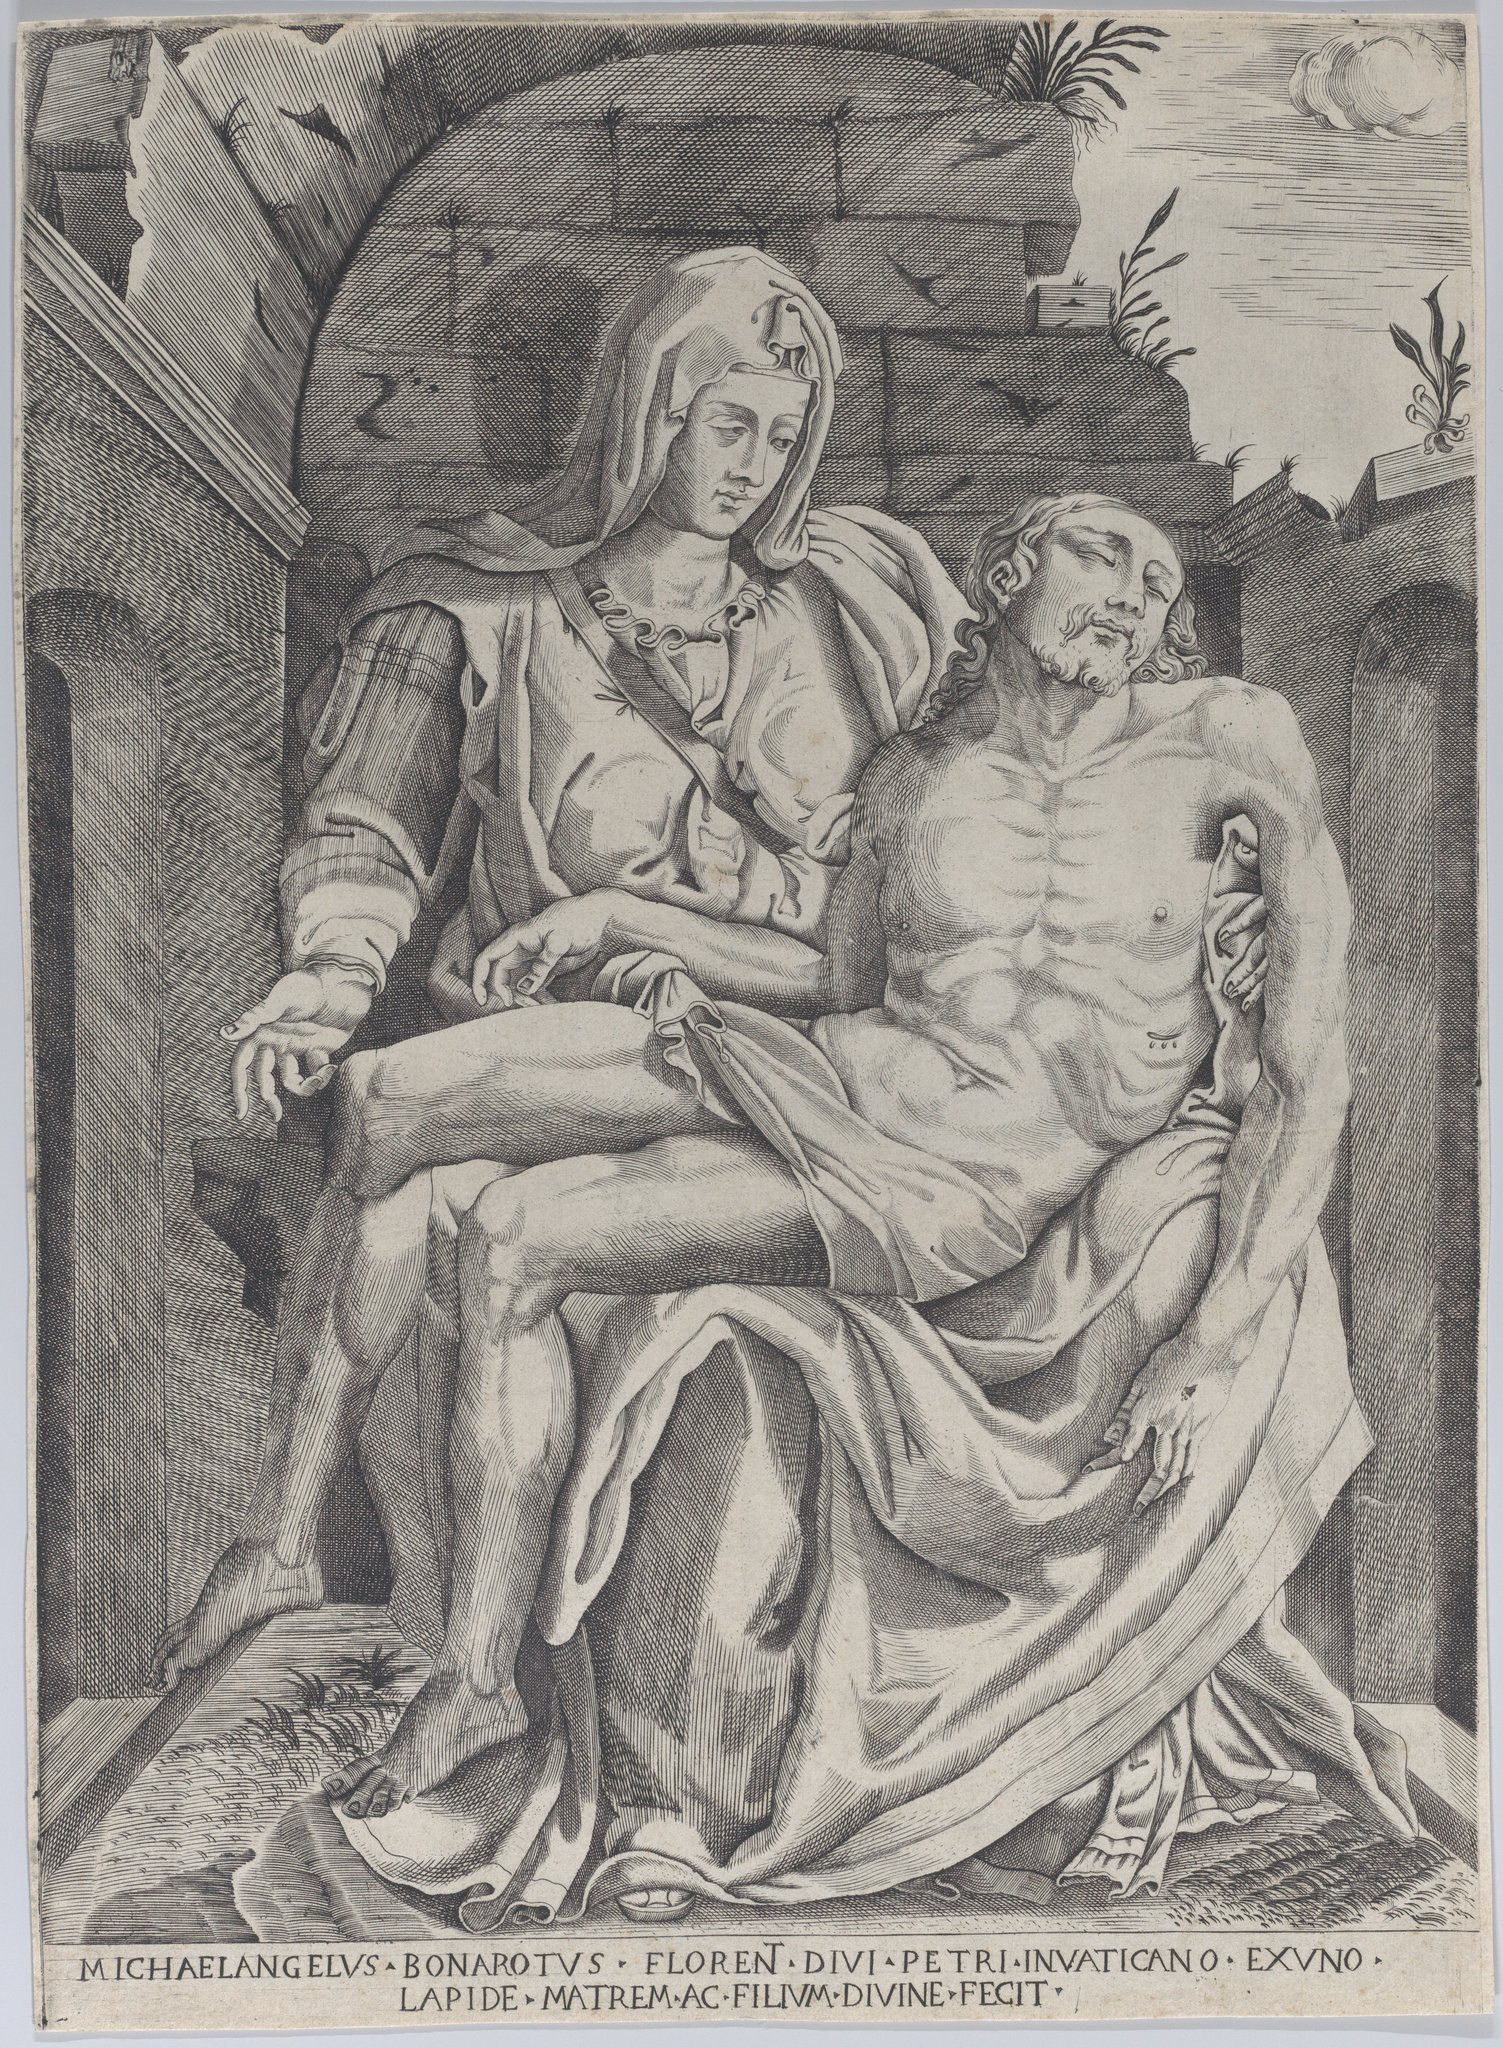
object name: print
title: Pietà, set against an arched ruin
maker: master of the name of jesus christ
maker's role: artist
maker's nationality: italian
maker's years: 1500-1600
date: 1556-1572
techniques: engraving